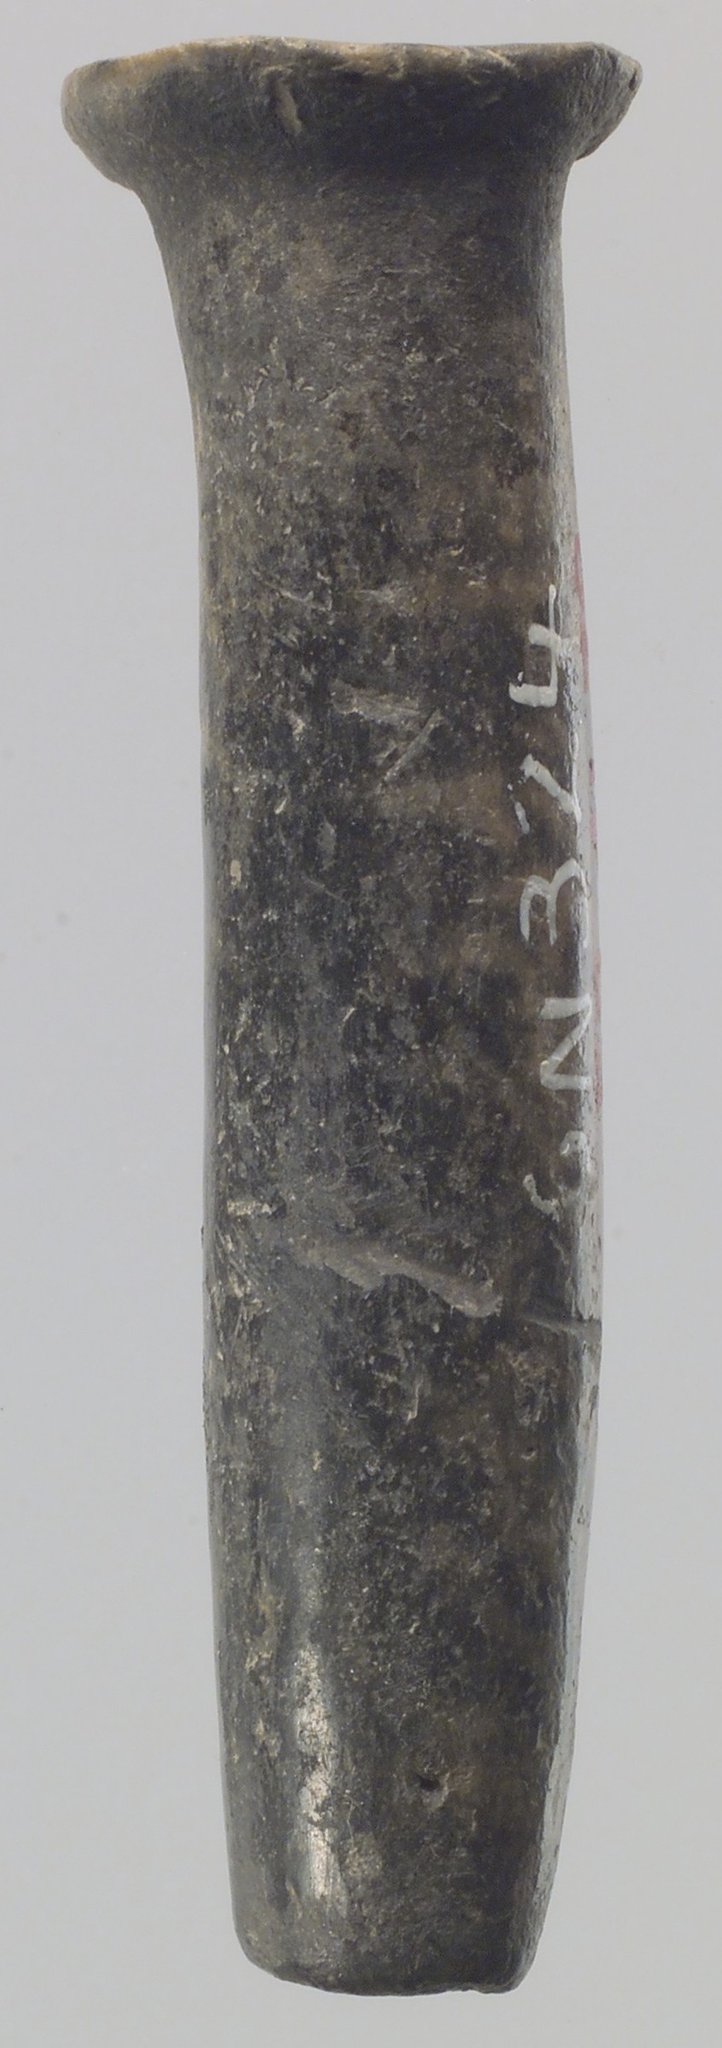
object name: nail or plug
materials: bone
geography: mesopotamia